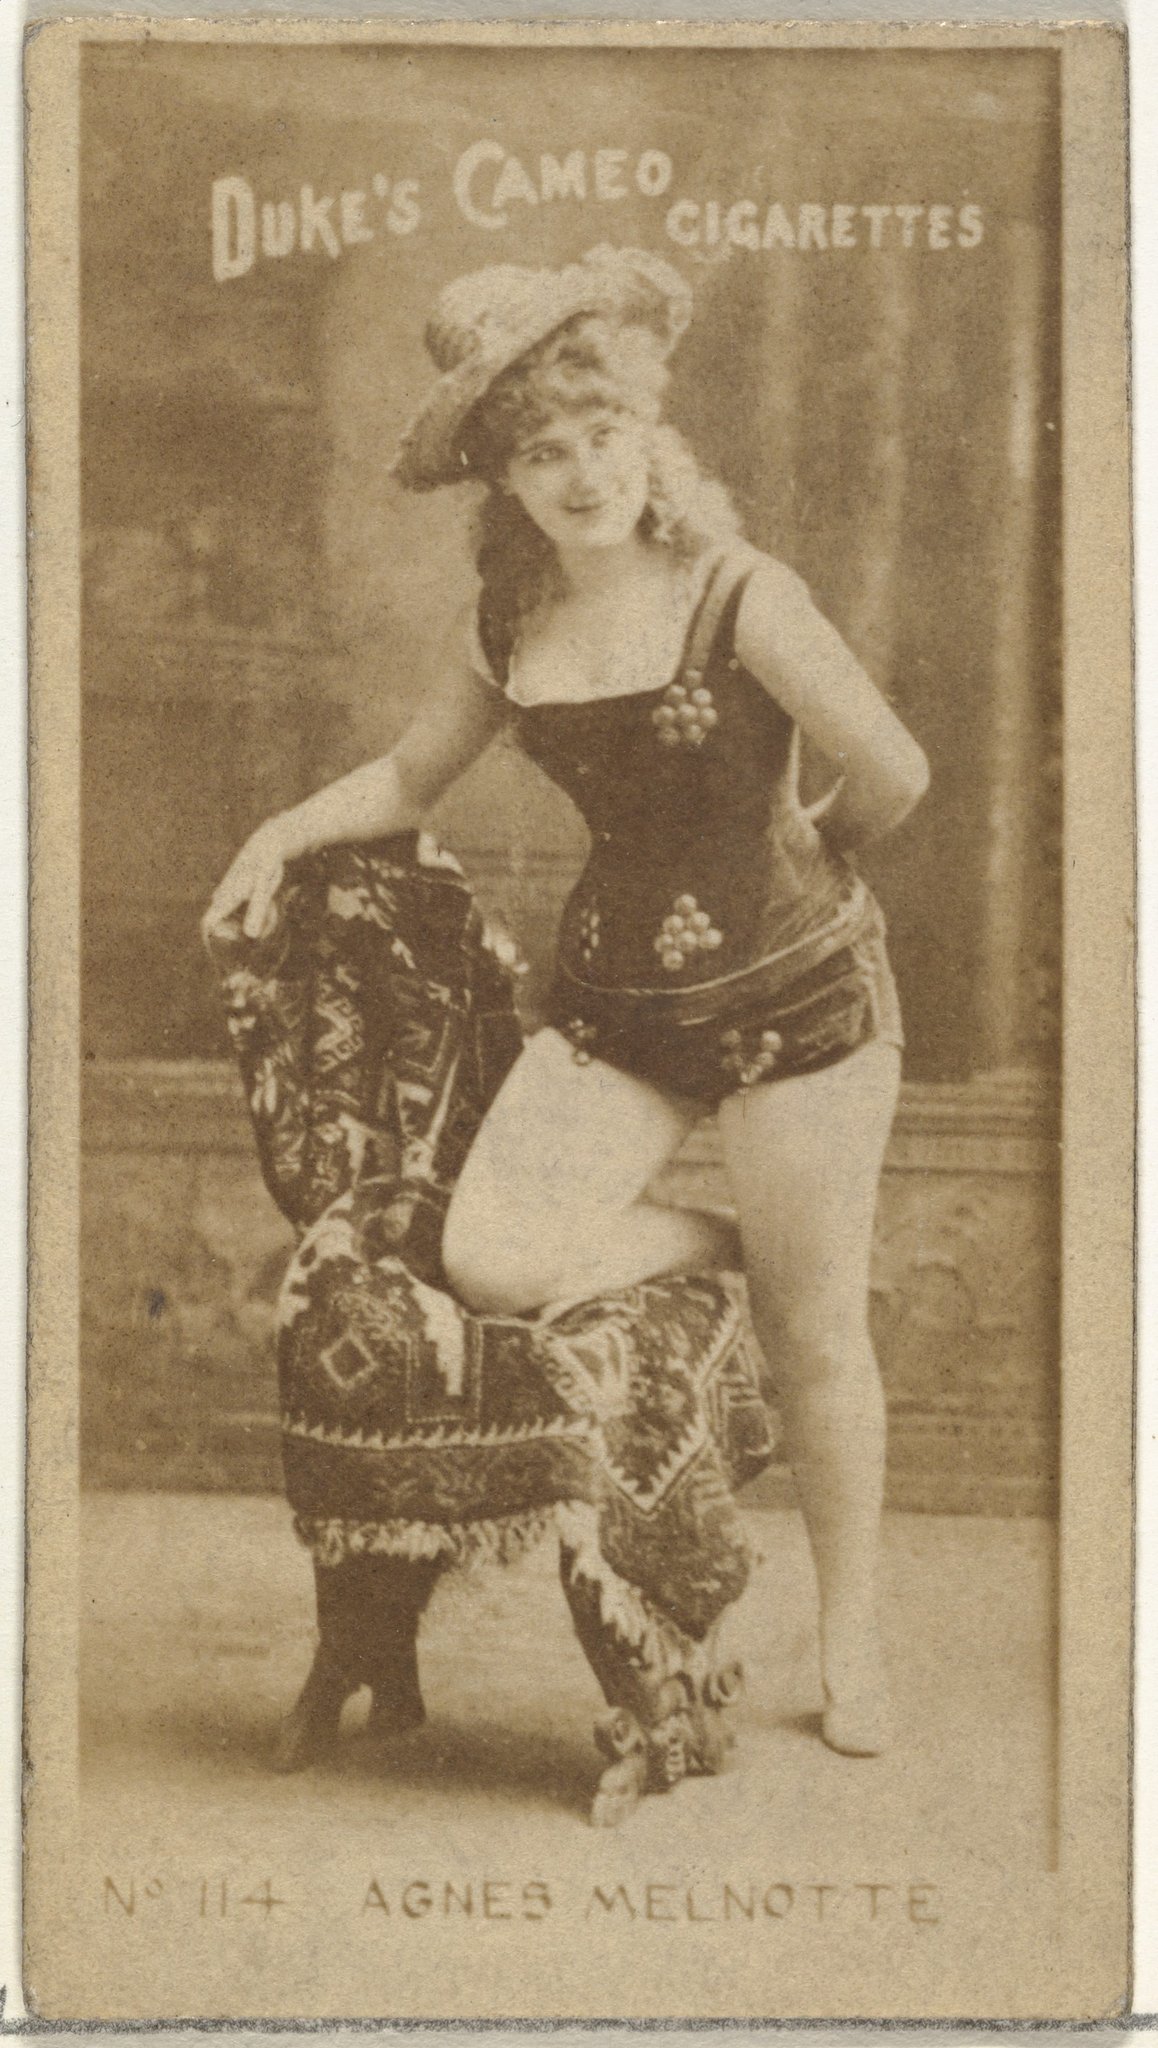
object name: photograph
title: Card Number 114, Agnes Melnotte, from the Actors and Actresses series (N145-4) issued by Duke Sons & Co. to promote Cameo Cigarettes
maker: w. duke, sons & co.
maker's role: publisher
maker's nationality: american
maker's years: 1870-1920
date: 1880-1889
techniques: albumen silver print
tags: portraits,women,actresses